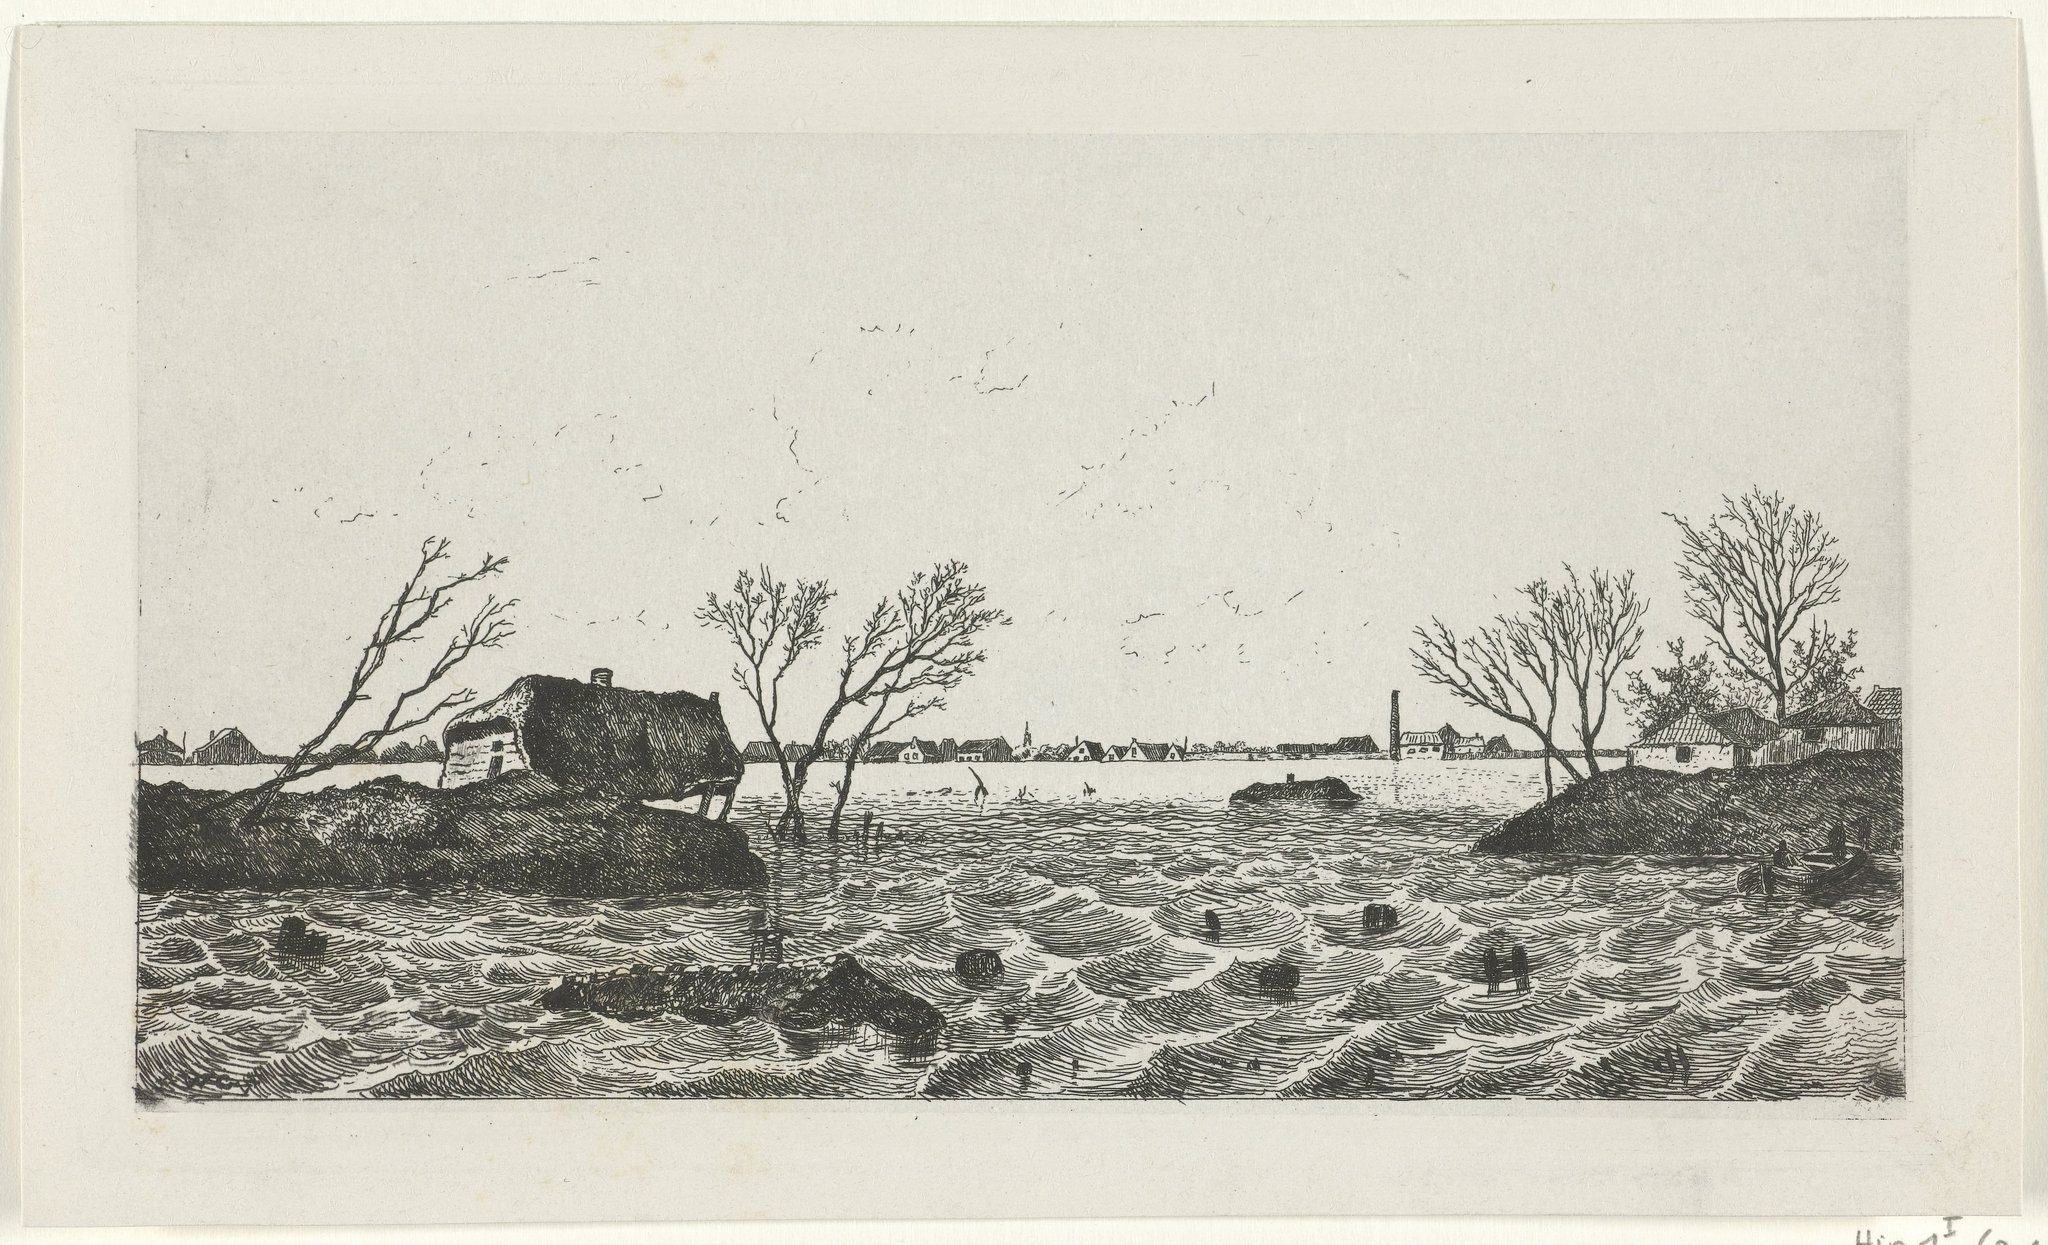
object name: print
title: Dijkdoorbraak bij Dreumel, 1855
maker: willem gruyter jr.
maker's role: draughtsman, print maker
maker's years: 1817-1880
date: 1832-1880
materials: paper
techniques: etching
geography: amsterdam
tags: dike-break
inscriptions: collector's mark: Lugt 2165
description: Landschap met dijkdoorbraak bij Dreumel tijdens de watersnoodramp in 1855.